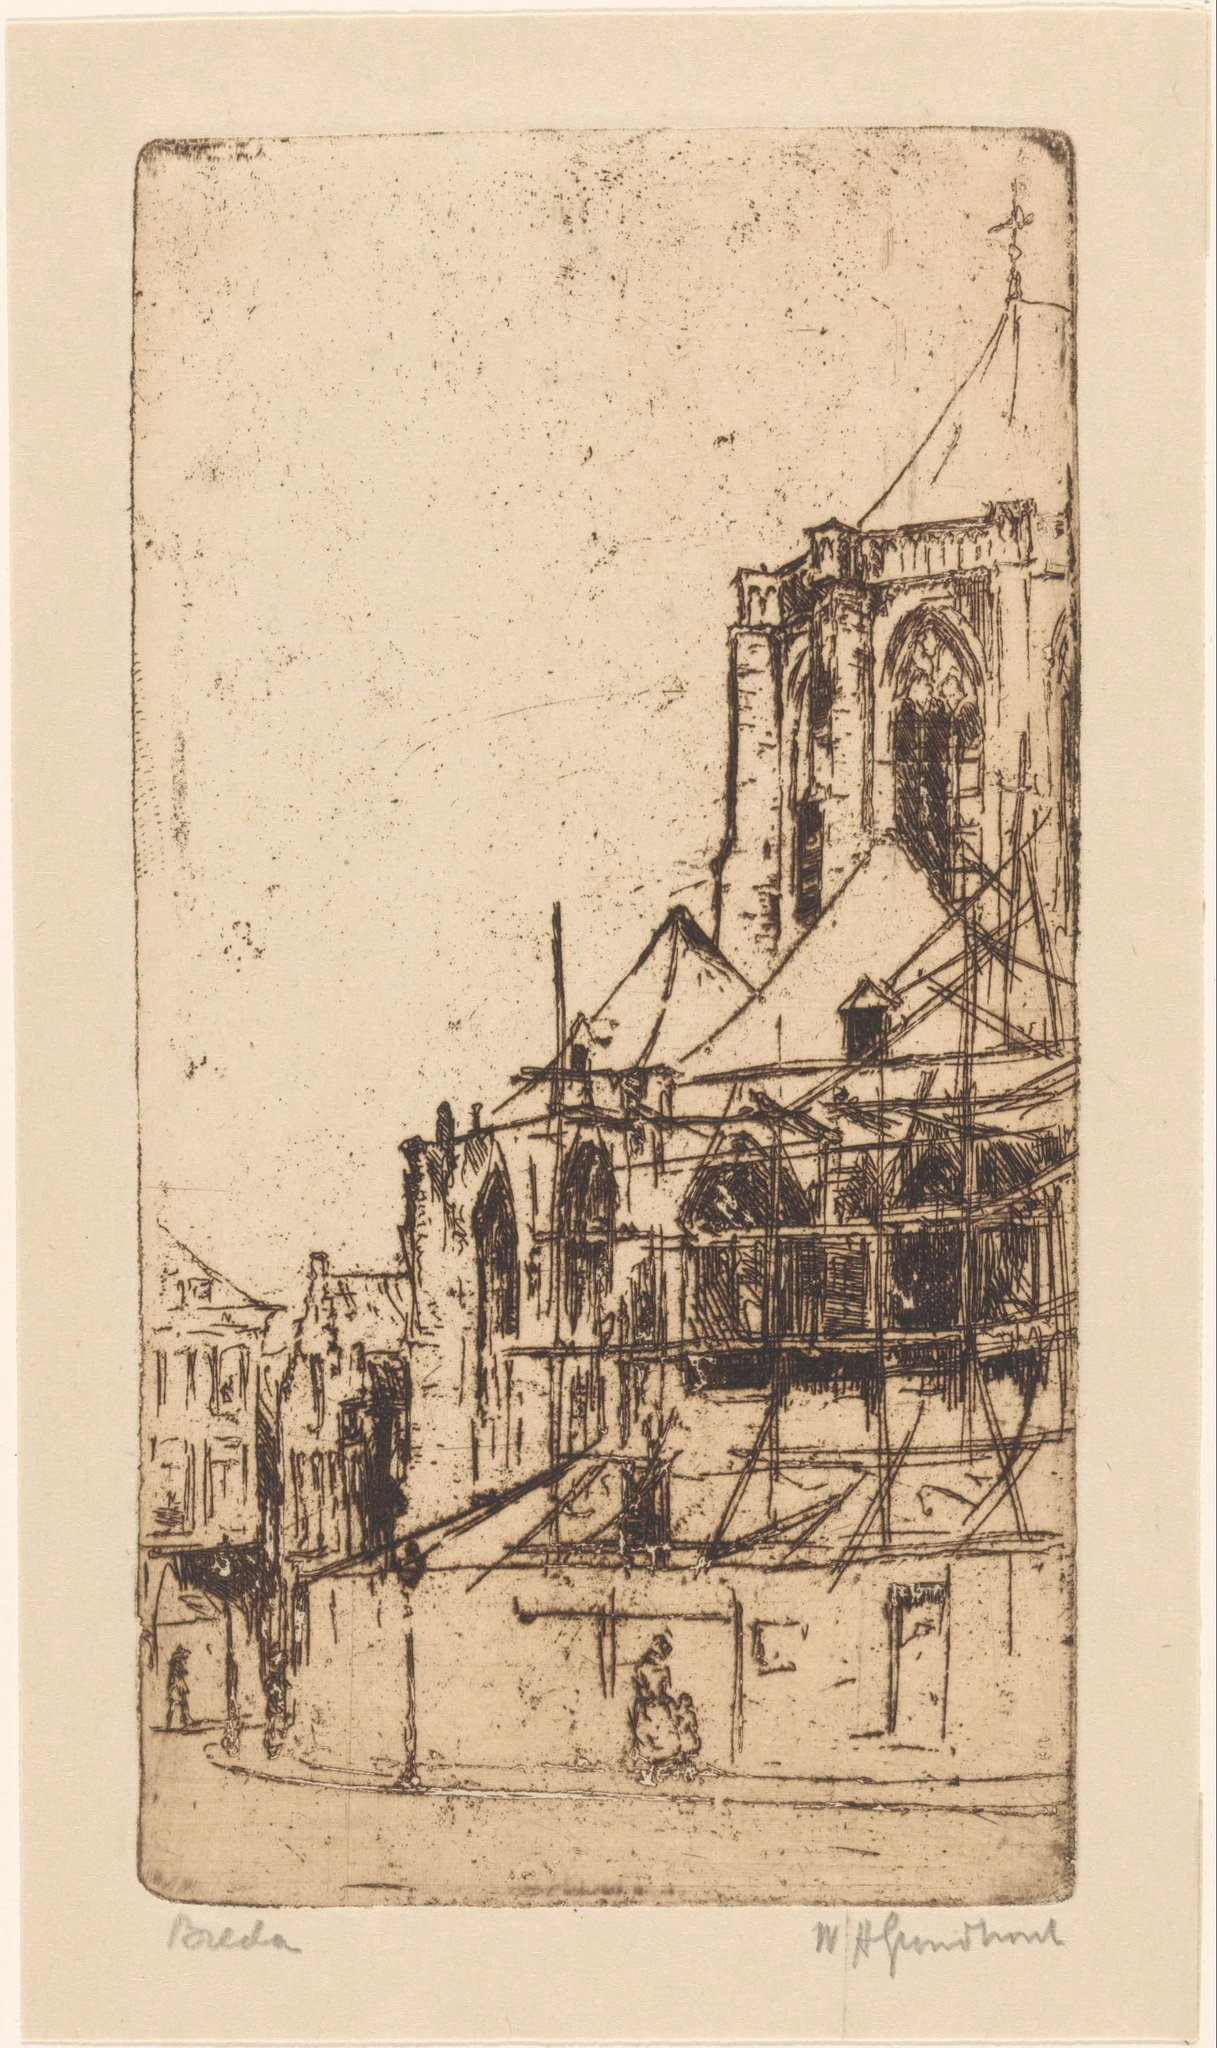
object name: print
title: Breda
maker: willem adrianus grondhout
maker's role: draughtsman, painter, print maker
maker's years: 1878-1934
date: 1888-1931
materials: paper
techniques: etching, intaglio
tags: church (exterior)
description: De Grote of Onze-Lieve-Vrouwekerk in Breda, gezien vanaf de Grote Markt.